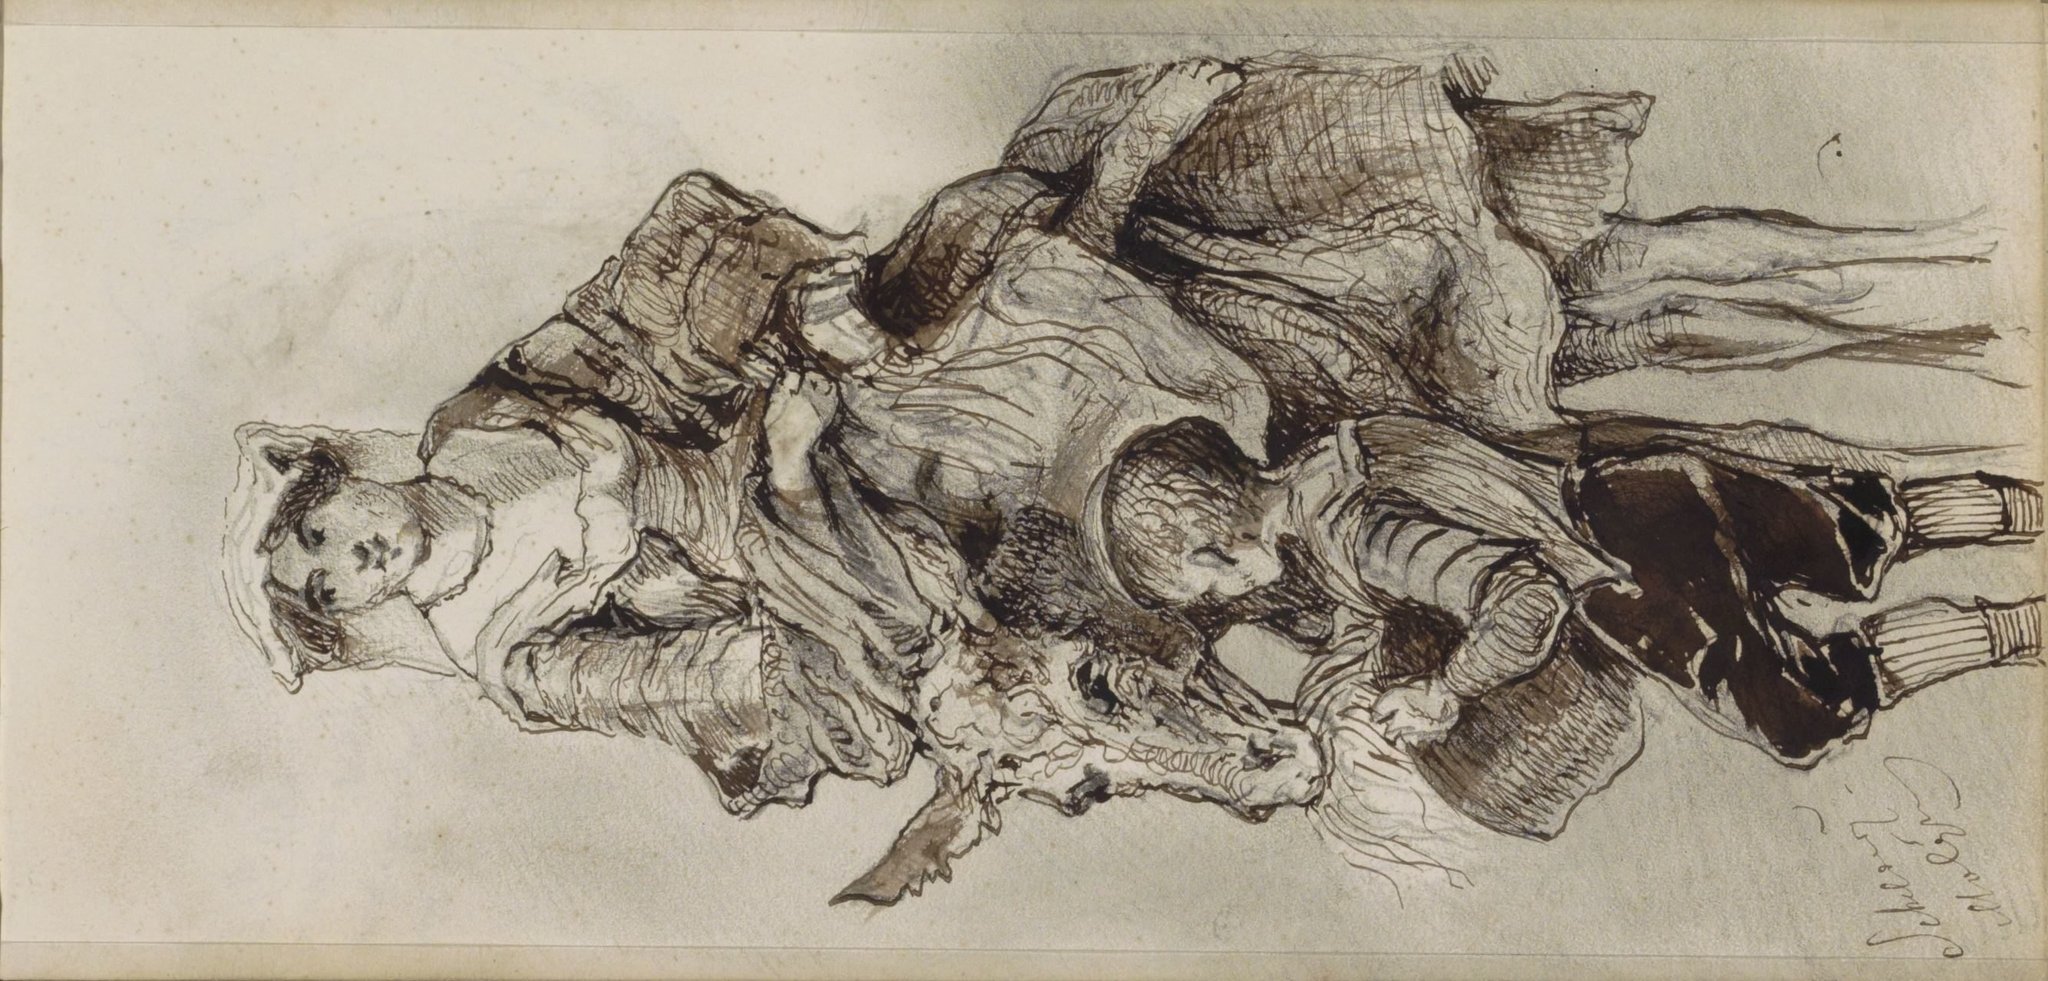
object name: sketchbook leaf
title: Vrouw zittend op een ezel die stro wordt gevoerd door een jongen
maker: johannes tavenraat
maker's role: draughtsman, painter, print maker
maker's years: 1809-1881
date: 1840-1868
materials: ink, paper, pencil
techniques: brush, pen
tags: sitting figure, adult woman, ass, donkey, boy (child between toddler and youth), feeding wild animals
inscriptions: annotation: ‘Schilderij/ Molijn’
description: Blad 28 recto uit een schetsboek met 63 bladen.